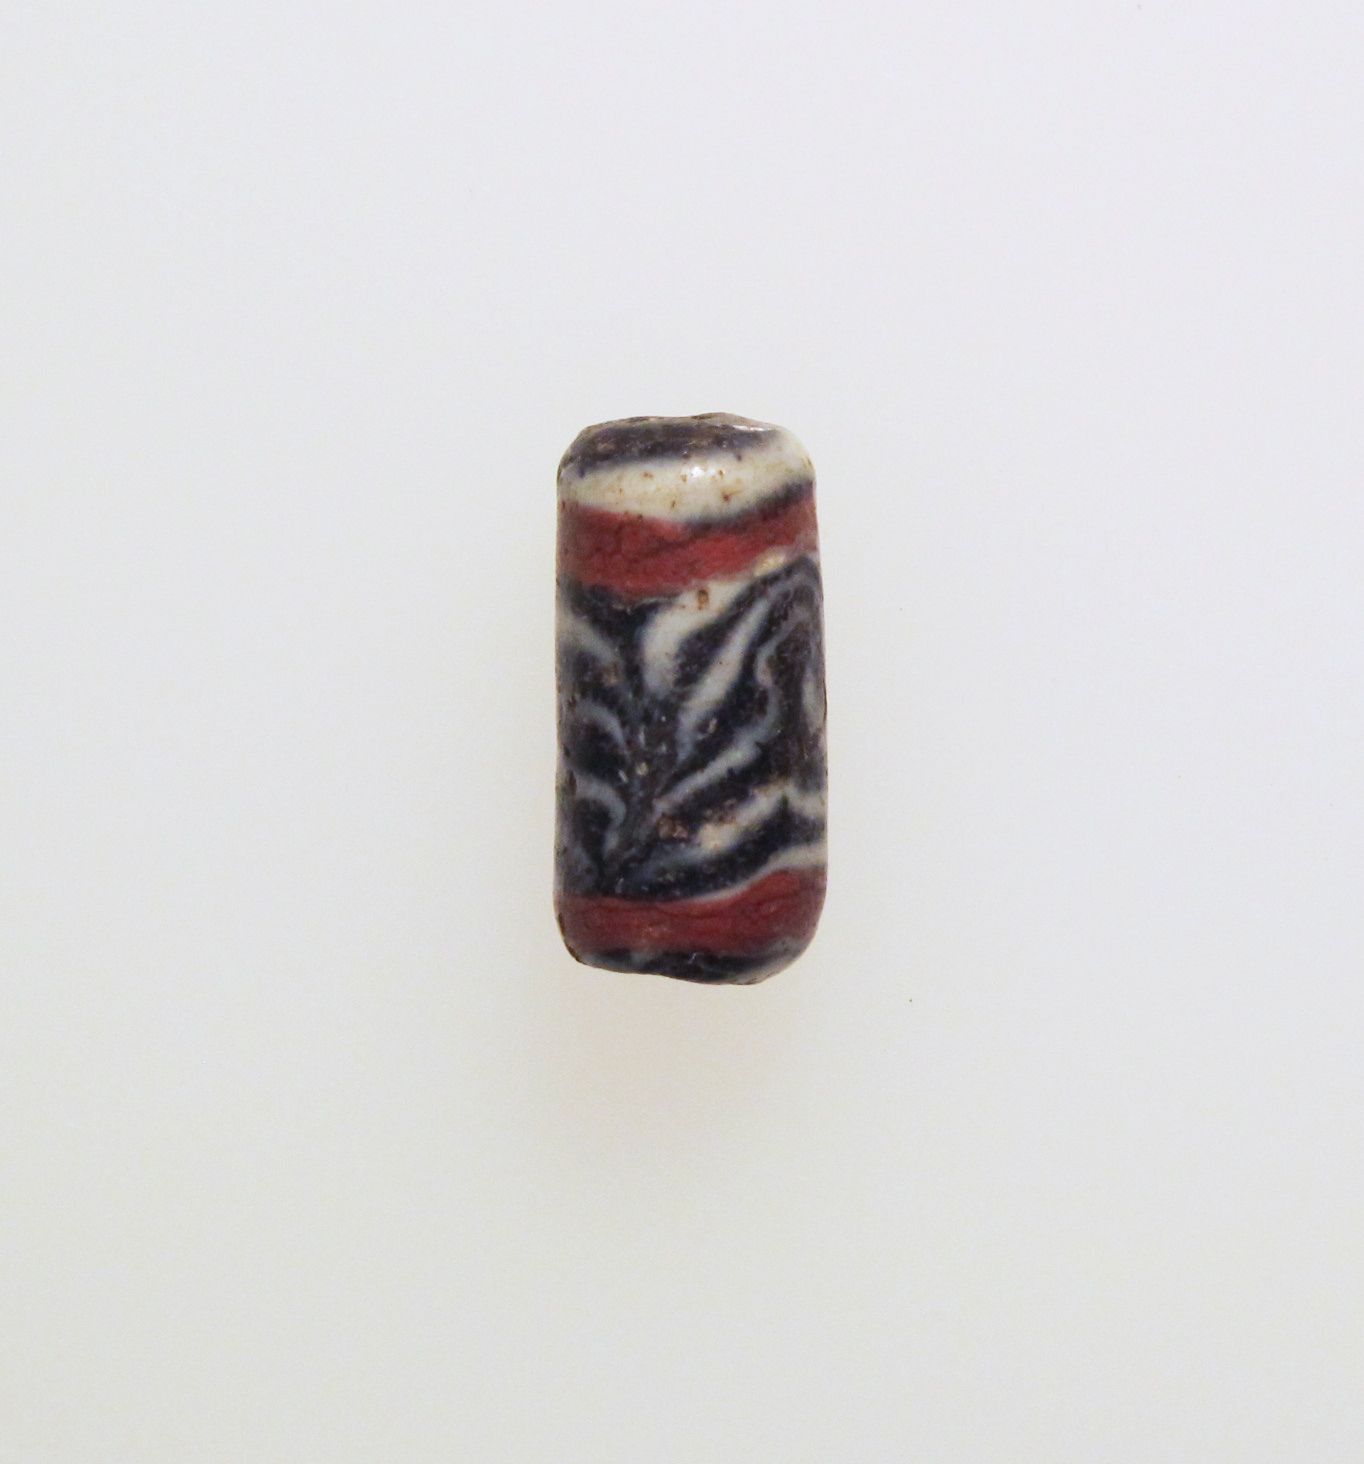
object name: bead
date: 7000 BCE-330 CE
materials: glass